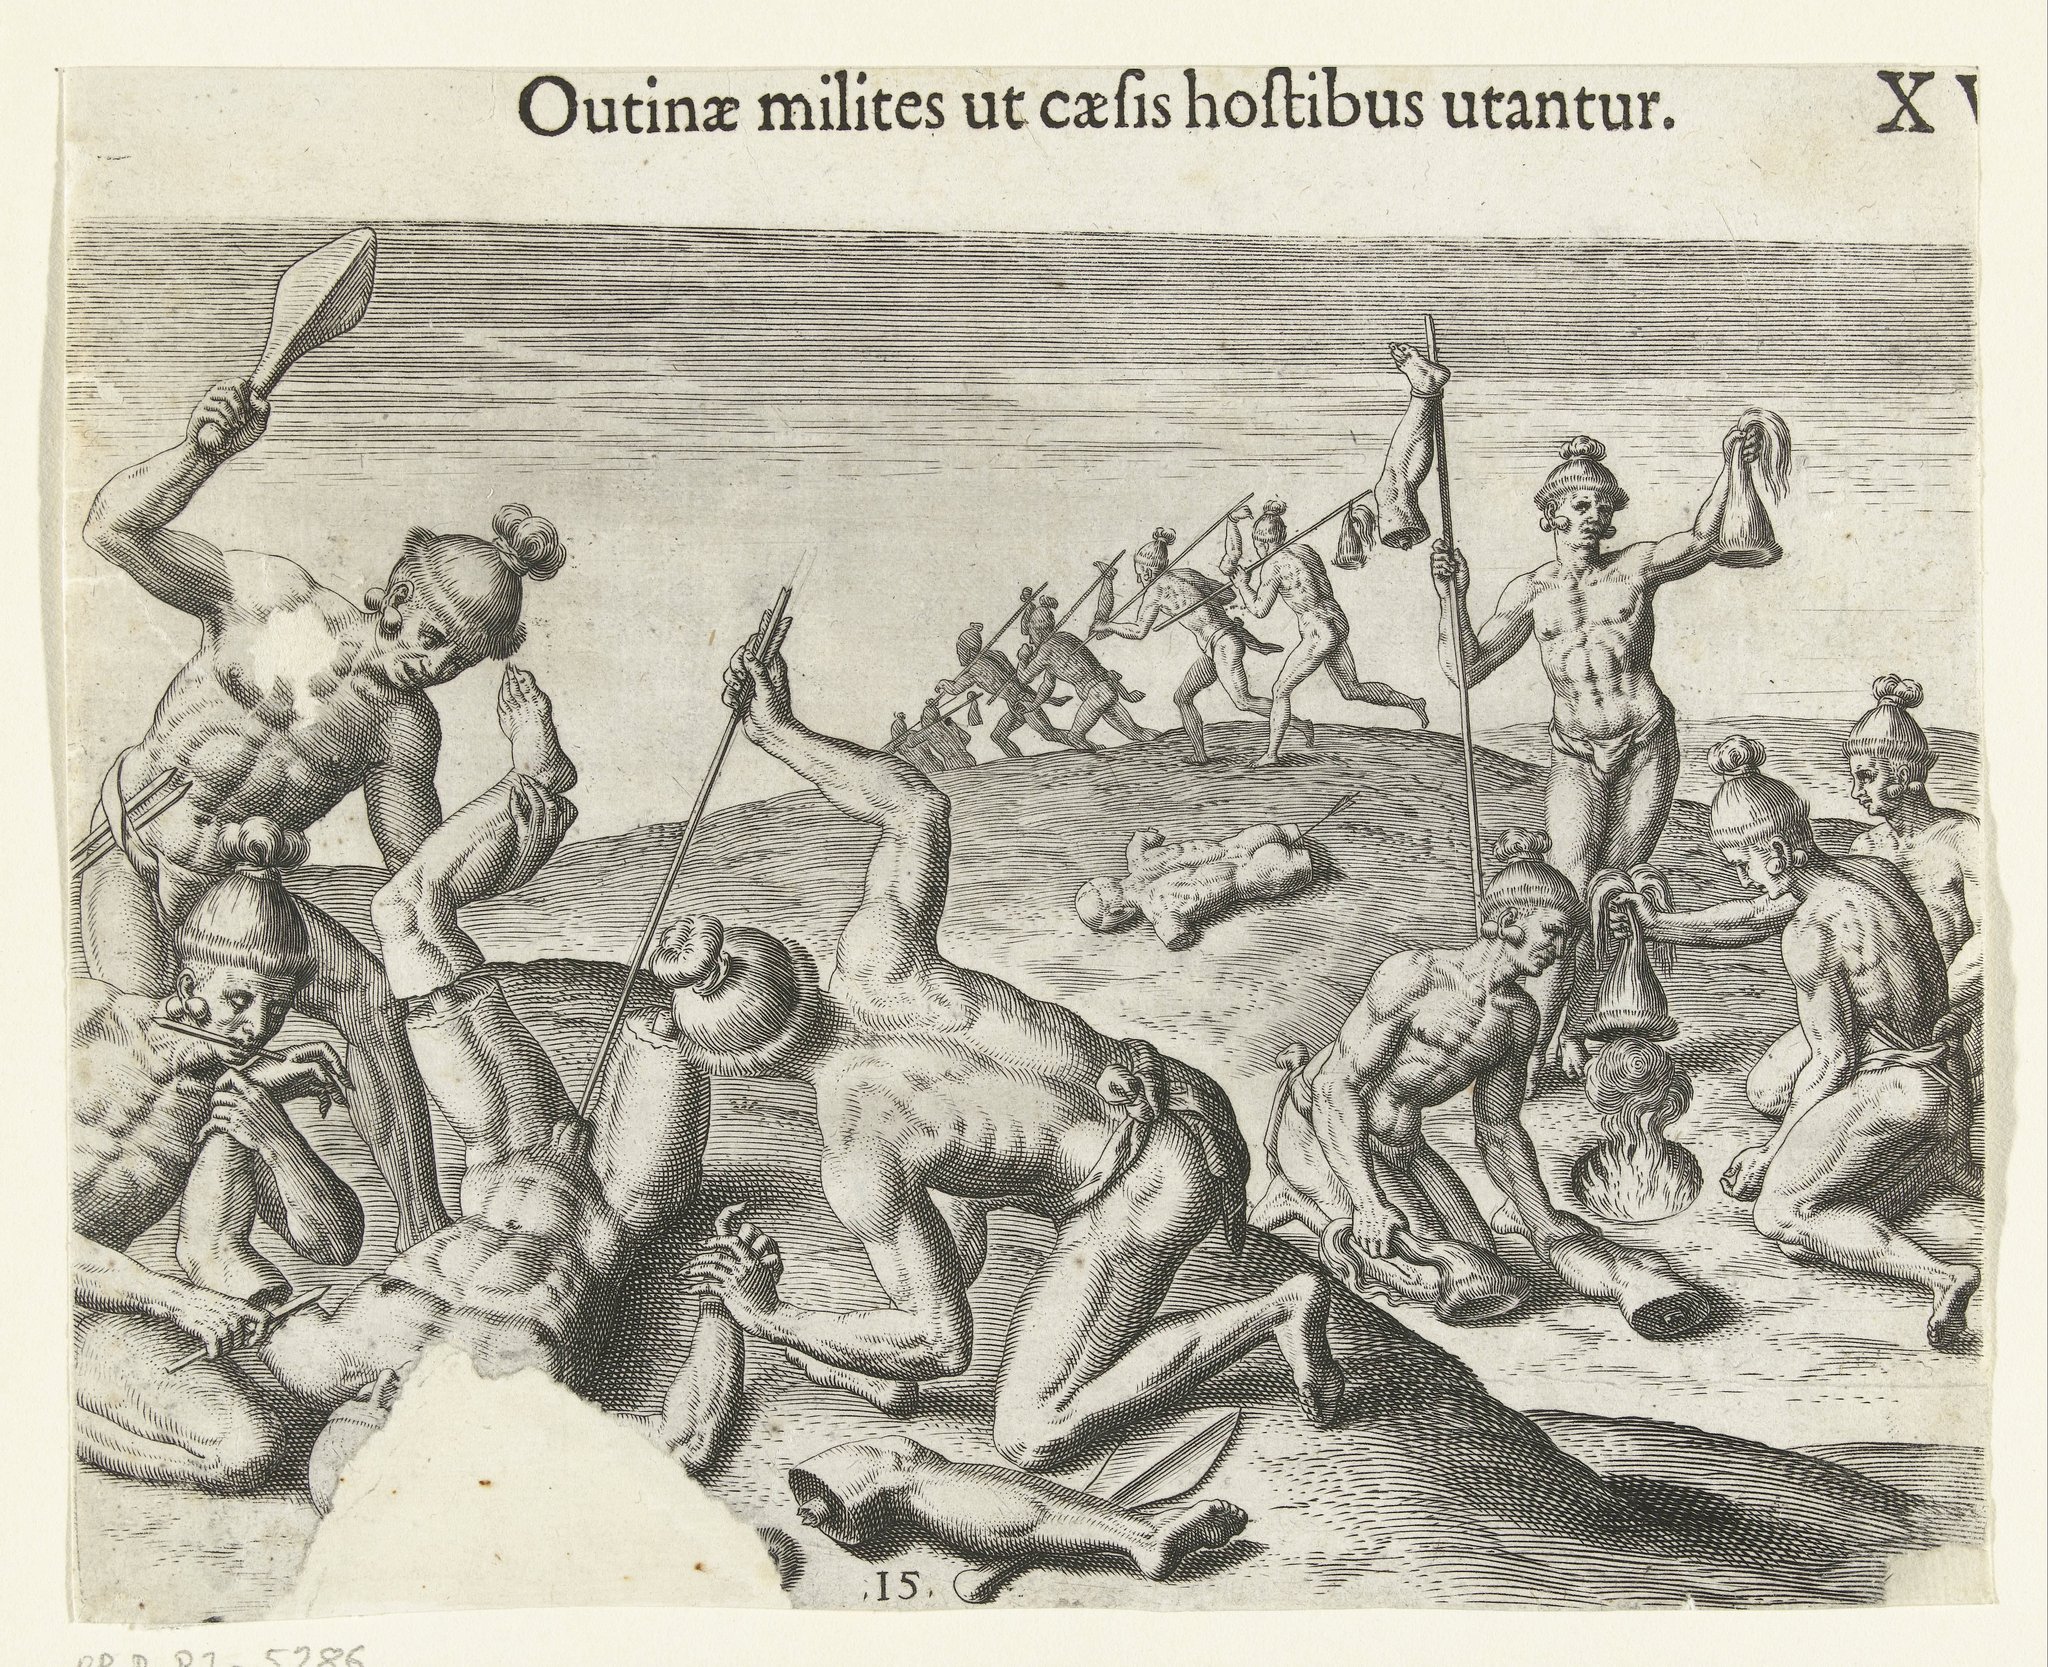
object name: book illustration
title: Utina martelen hun gevangenen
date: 1591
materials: paper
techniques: engraving, letterpress printing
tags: indigenous peoples of north america, pulling out one's hair, violent death, being killed; being mishandled and maltreated; seeking death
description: Afkomstig uit: Collectiones peregrinationum in Indiam occidentalem, dl. 2: René de Laudonnière, Brevis narratio eorum quae in Florida Americae provincia Gallis acciderunt. Frankfurt am Main: J. Wechelus, 1591.